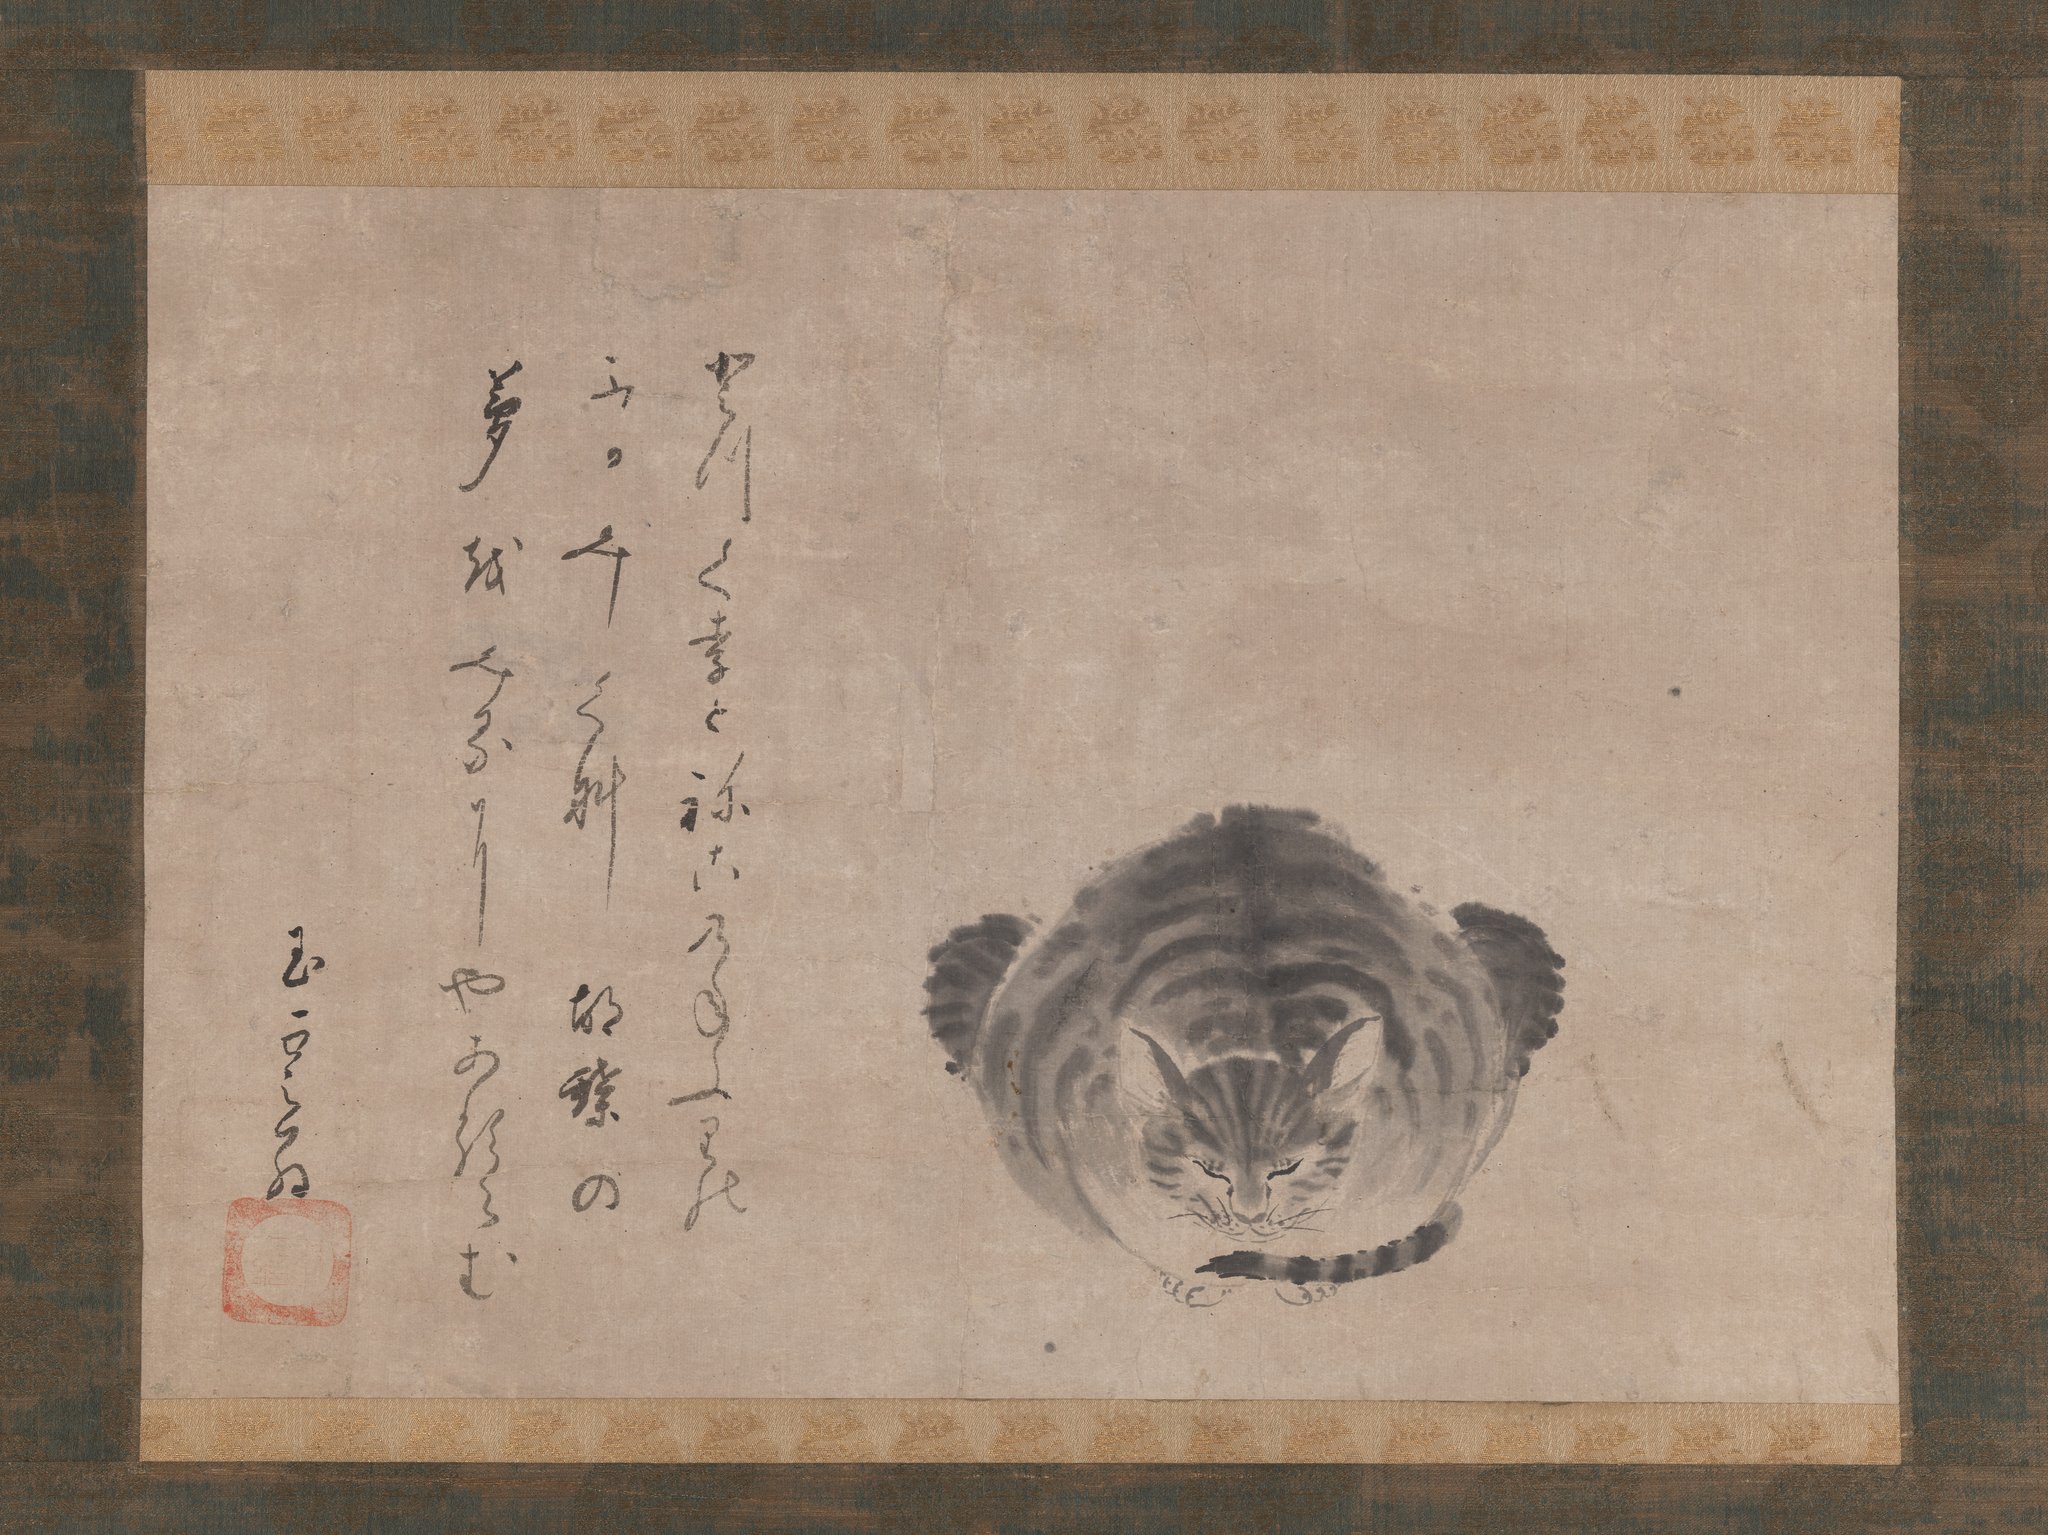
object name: hanging scroll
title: Dreaming Cat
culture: japanese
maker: hōzōbō shinkai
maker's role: artist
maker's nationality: japanese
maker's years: 1626-1688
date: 1634-1666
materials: ink, paper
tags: cats